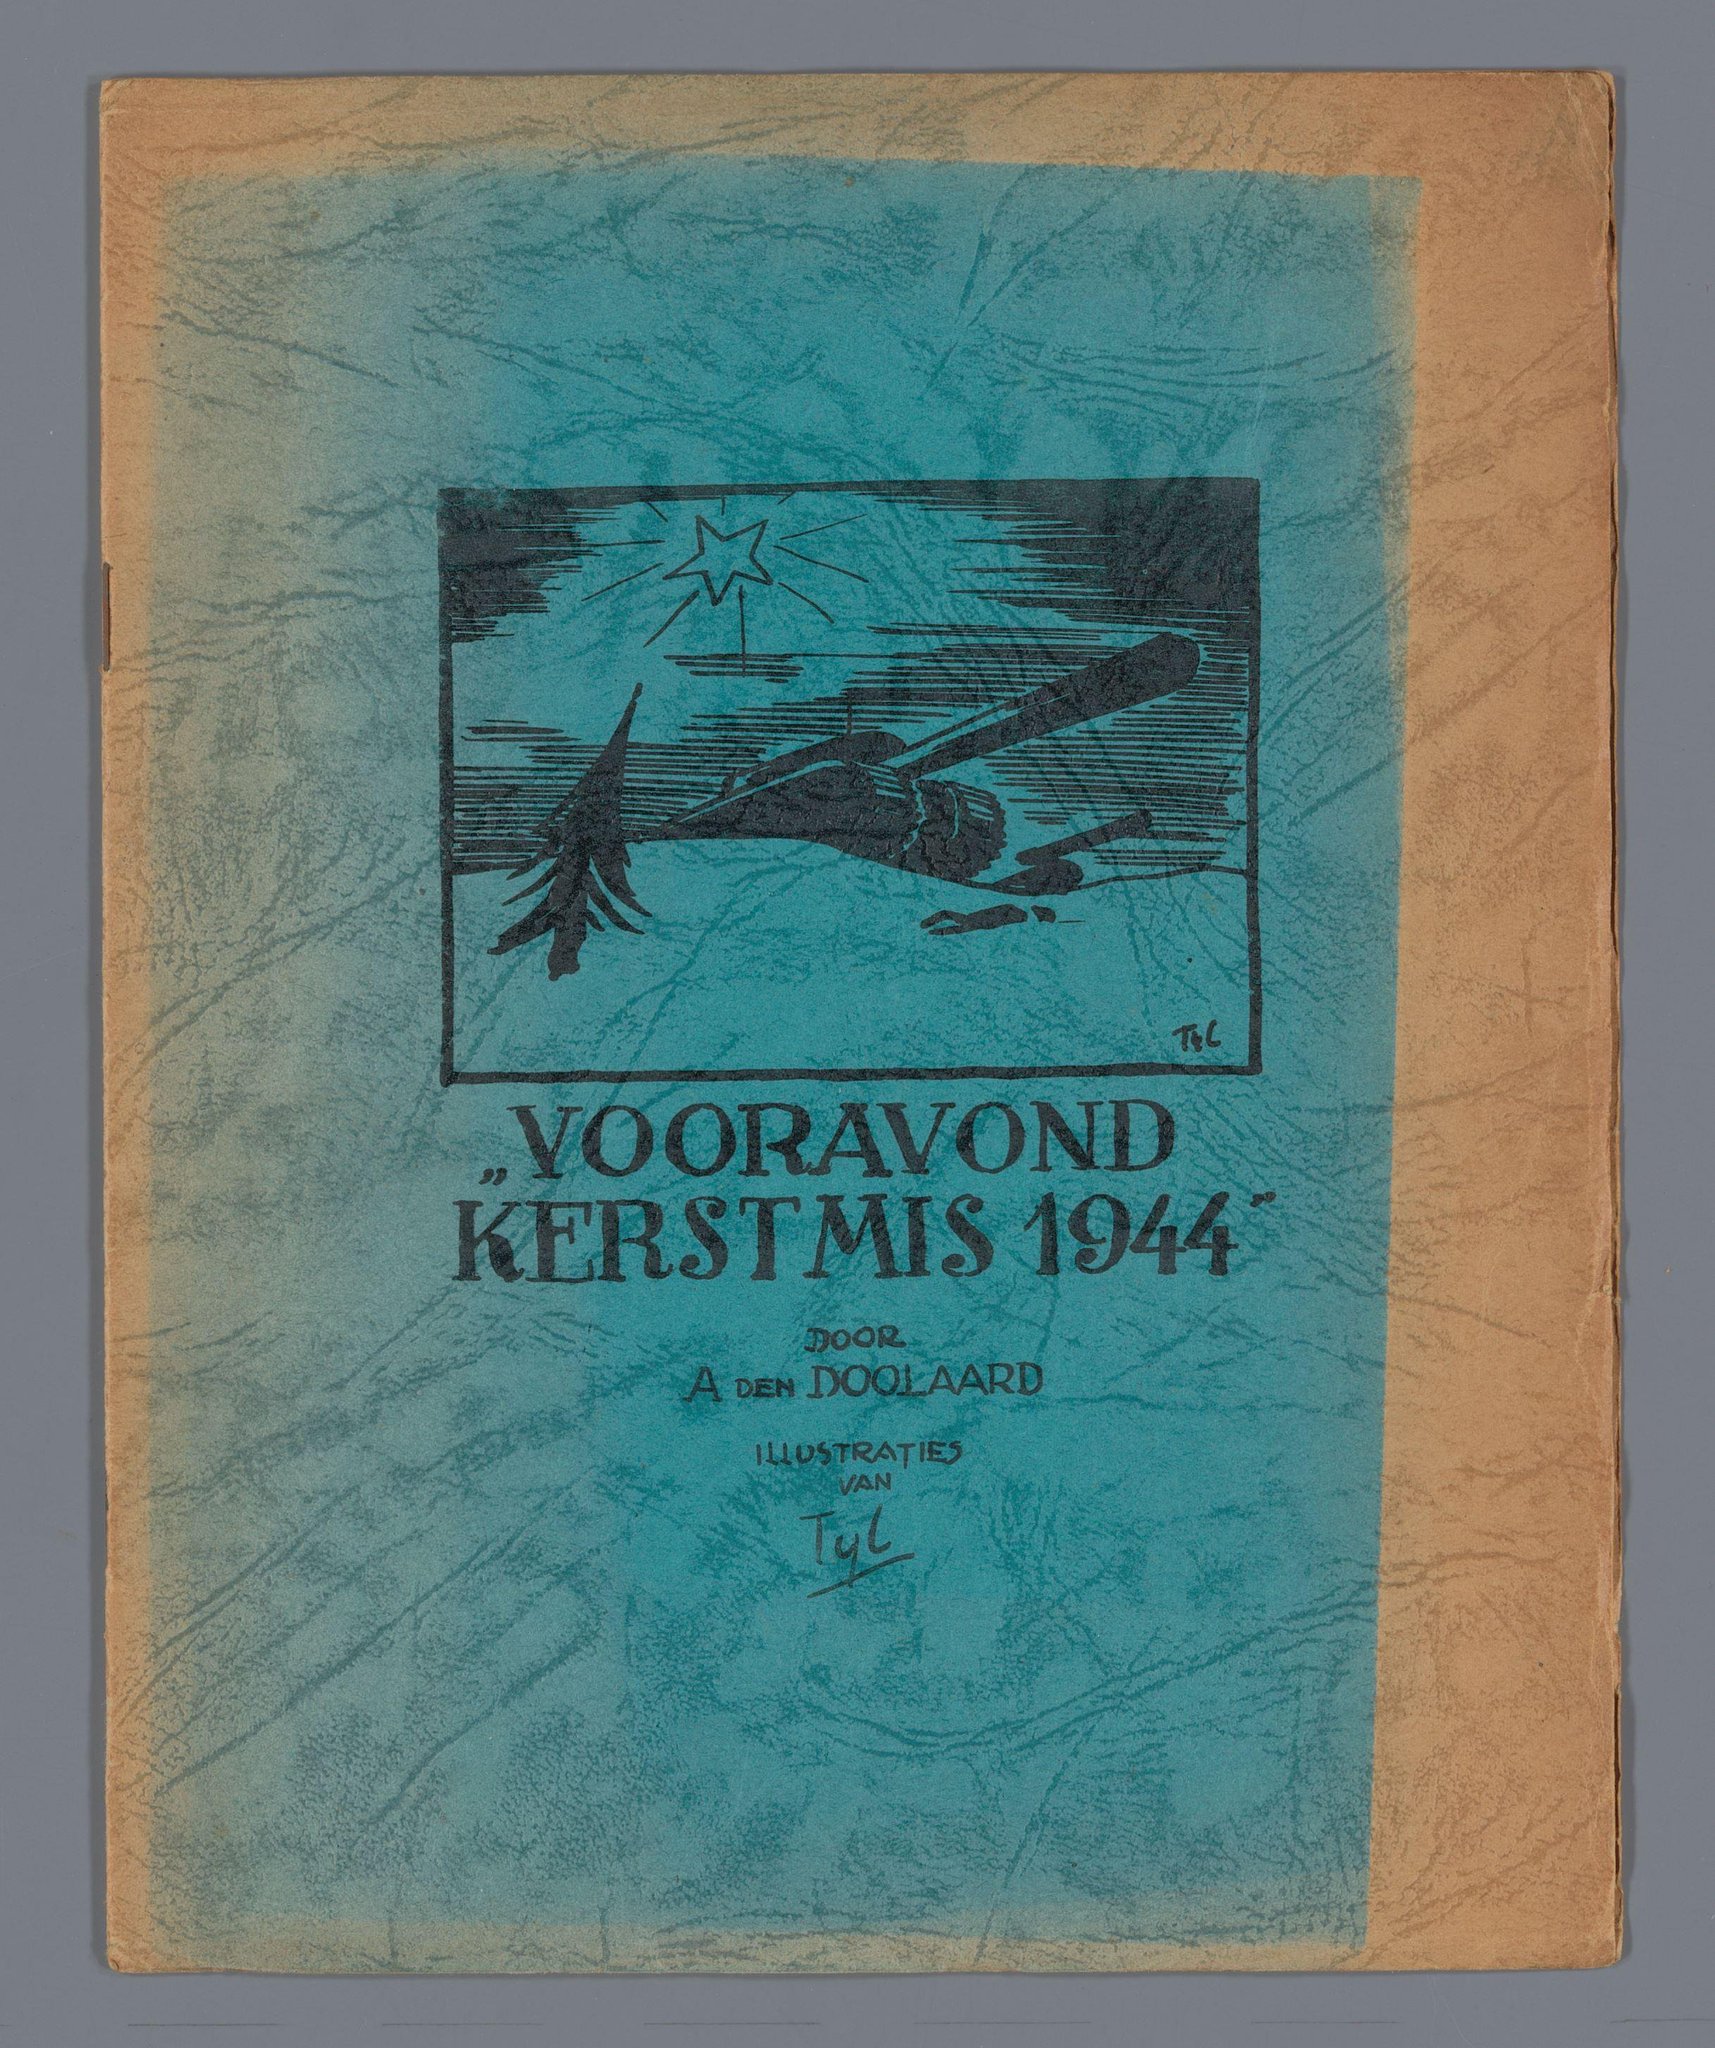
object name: brochure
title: Gedicht van A. den Doolaard 'Vooravond kerstmis 1944' met illustraties van Tijl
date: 1912-1944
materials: paper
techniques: printing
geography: netherlands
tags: a. den doolaard, deventer, painter, tijl, modern forms of military vehicles (tank)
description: Geniete bundel van 12 gedrukte pagina's. Uitgave Het Stichtse Pepertje. Kaft van bruin geaderd papier met blauwe opdruk met tekst 'Vooravond Kerstmis 1944', 'door A. den Doolaard', 'Illustraties van Tijl'. Afbeelding van tank onder de kerstster. In colophon achterin: 'De opbrengst van deze uitgave dient ter ondersteuning van het illegale werk'.